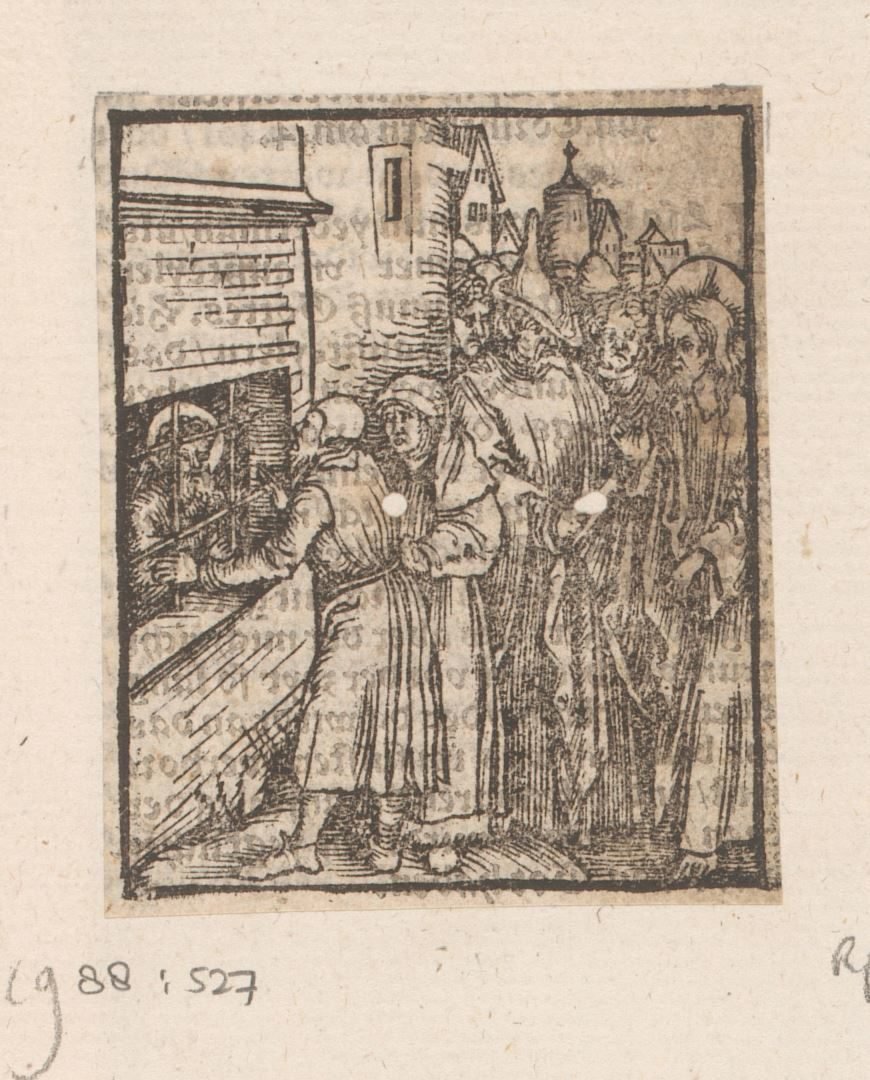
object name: book illustration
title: Christus zendt de discipelen naar Johannes de Doper die in de gevangenis zit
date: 1536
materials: paper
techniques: woodcut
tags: prison, jail, john the baptist in prison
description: Prent afkomstig uit: Evangelia und Epistel. Neurenberg: Hans Guldenmund, 1536.